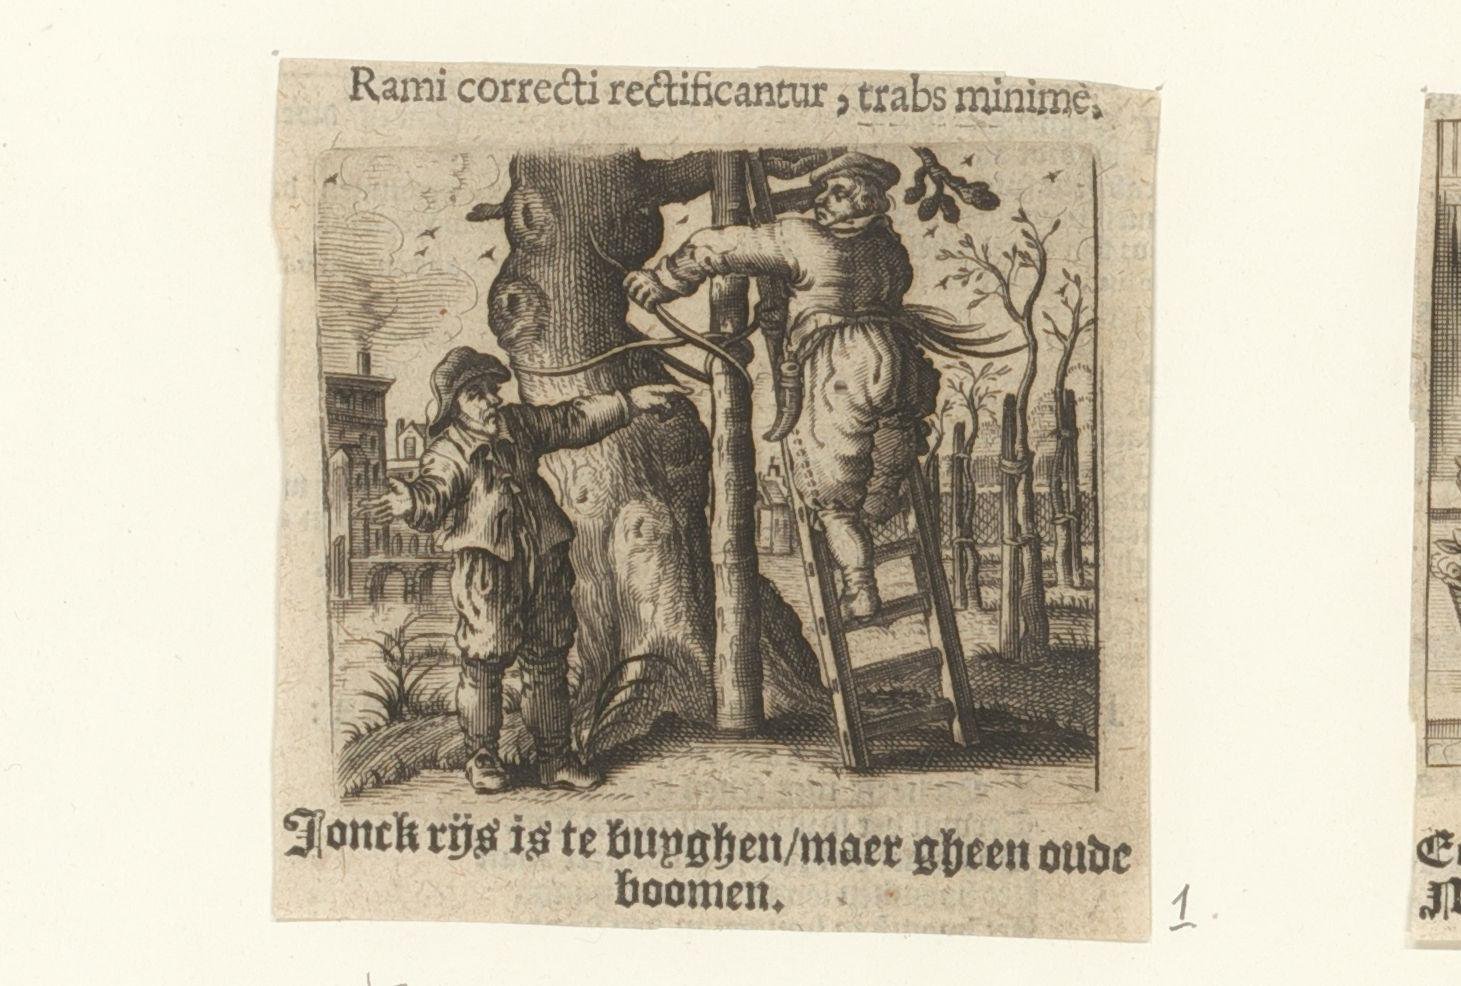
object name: book illustration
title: Twee mannen proberen een oude kromme boom recht te trekken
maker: Anonymous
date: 1635-1715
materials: paper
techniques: engraving, letterpress printing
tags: forester, trees, proverbs, sayings, etc., intention, purpose, aim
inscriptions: collector's mark: Lugt 1641, stamp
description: Veel versies van dit embleem verschenen in verschillende uitgave van Spiegel van den Ouden ende Nieuwen Tydt. Zoals: Cats, Jacob. Spiegel van den Ouden ende Nieuwen-tijt, Bestaende uyt Spreeck-woorden (...). Dordrecht: Jacob Braat, 1647. Maar ook in andere publicaties (1665, 1671, 1715, 1722).